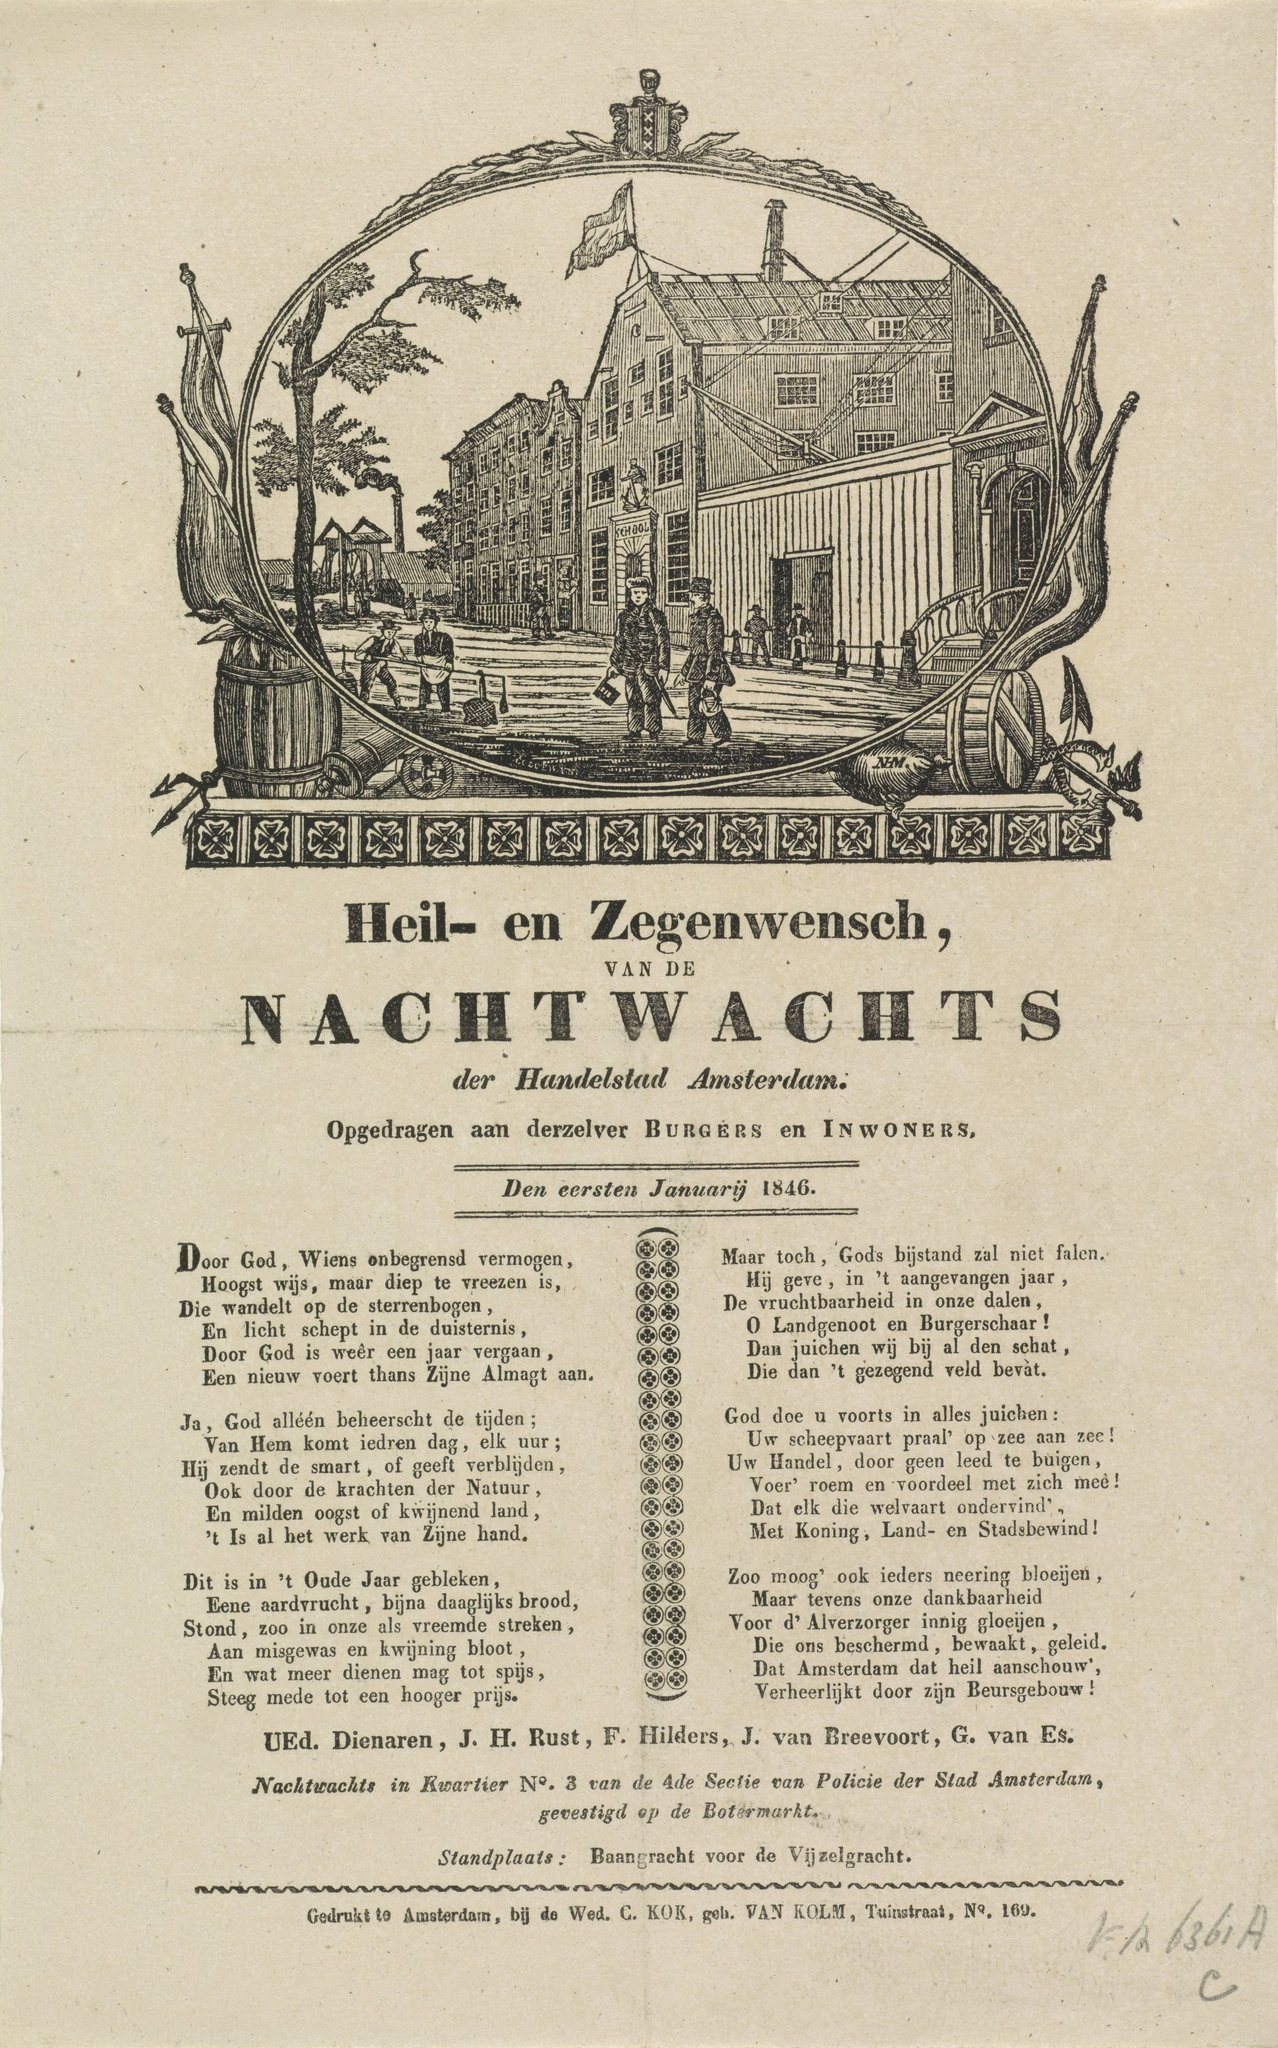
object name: new year card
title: Nieuwjaarswens van de Amsterdamse nachtwacht voor het jaar 1846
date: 1845-1846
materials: paper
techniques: letterpress printing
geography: netherlands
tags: night patrol, street, amsterdam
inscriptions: collector's mark: Lugt 2228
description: Nieuwjaarswens van de Amsterdamse nachtwacht (ratelwacht) voor het jaar 1846. Ovale voorstelling van de IJgracht met de oude Kweekschool voor de Zeevaart aan de Buitenkant (Prins Hendrikkade), met twee leden van de nachtwacht. Met een vers in twee kolommen. Namens de nachtwacht in kwartier No. 3 van de 4de Sectie van Policie der stad Amsterdam: J.H. Rust, F. Hilders, J. van Breevoort en G. van Es.